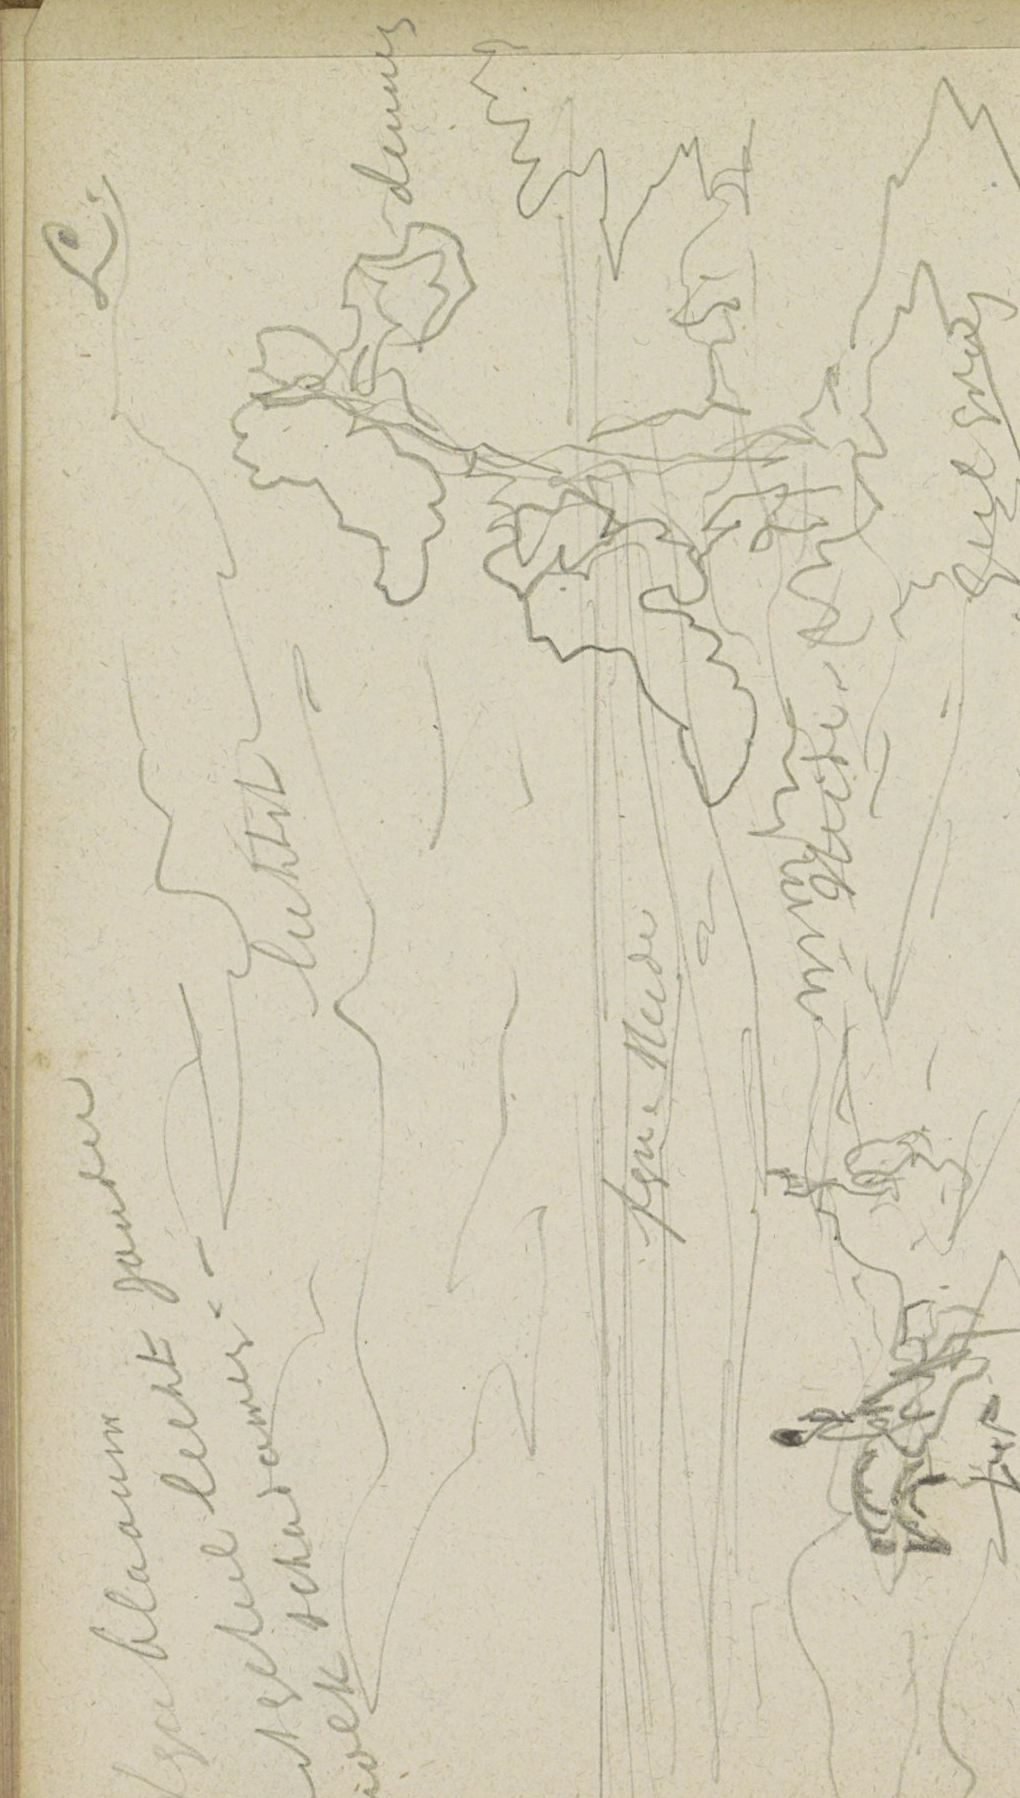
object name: sketchbook leaf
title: Heidelandschap met dennenbomen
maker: johannes tavenraat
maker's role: draughtsman, painter, print maker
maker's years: 1809-1881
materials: paper, pencil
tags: landscapes, trees: fir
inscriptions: kleurnotitie, handgeschreven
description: Blad 40 verso uit een schetsboek met 88 bladen.